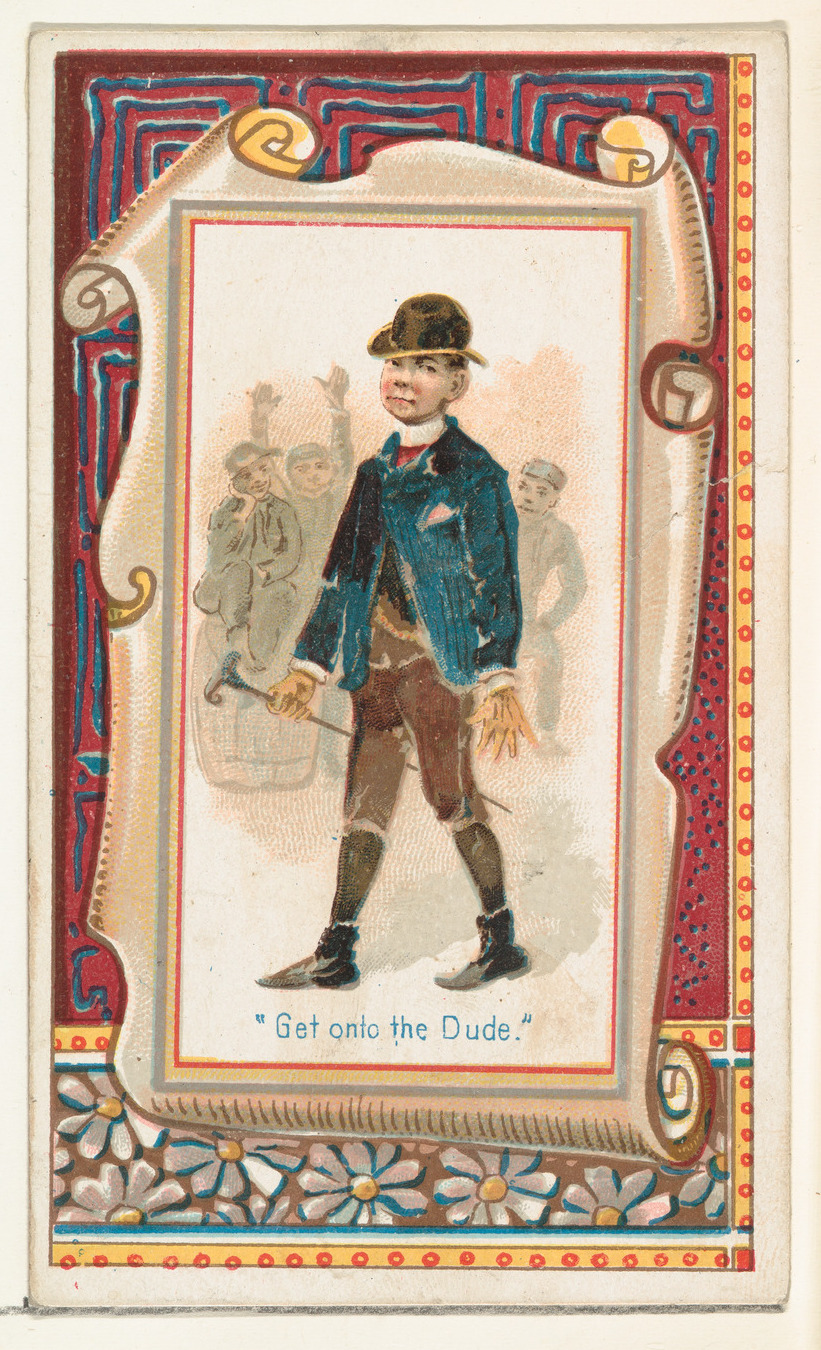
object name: print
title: "Get onto the Dude," from the Terrors of America set (N136) issued by Duke Sons & Co. to promote Honest Long Cut Tobacco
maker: w. duke, sons & co.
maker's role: publisher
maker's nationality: american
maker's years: 1870-1920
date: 1888-1889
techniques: color lithograph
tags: boys